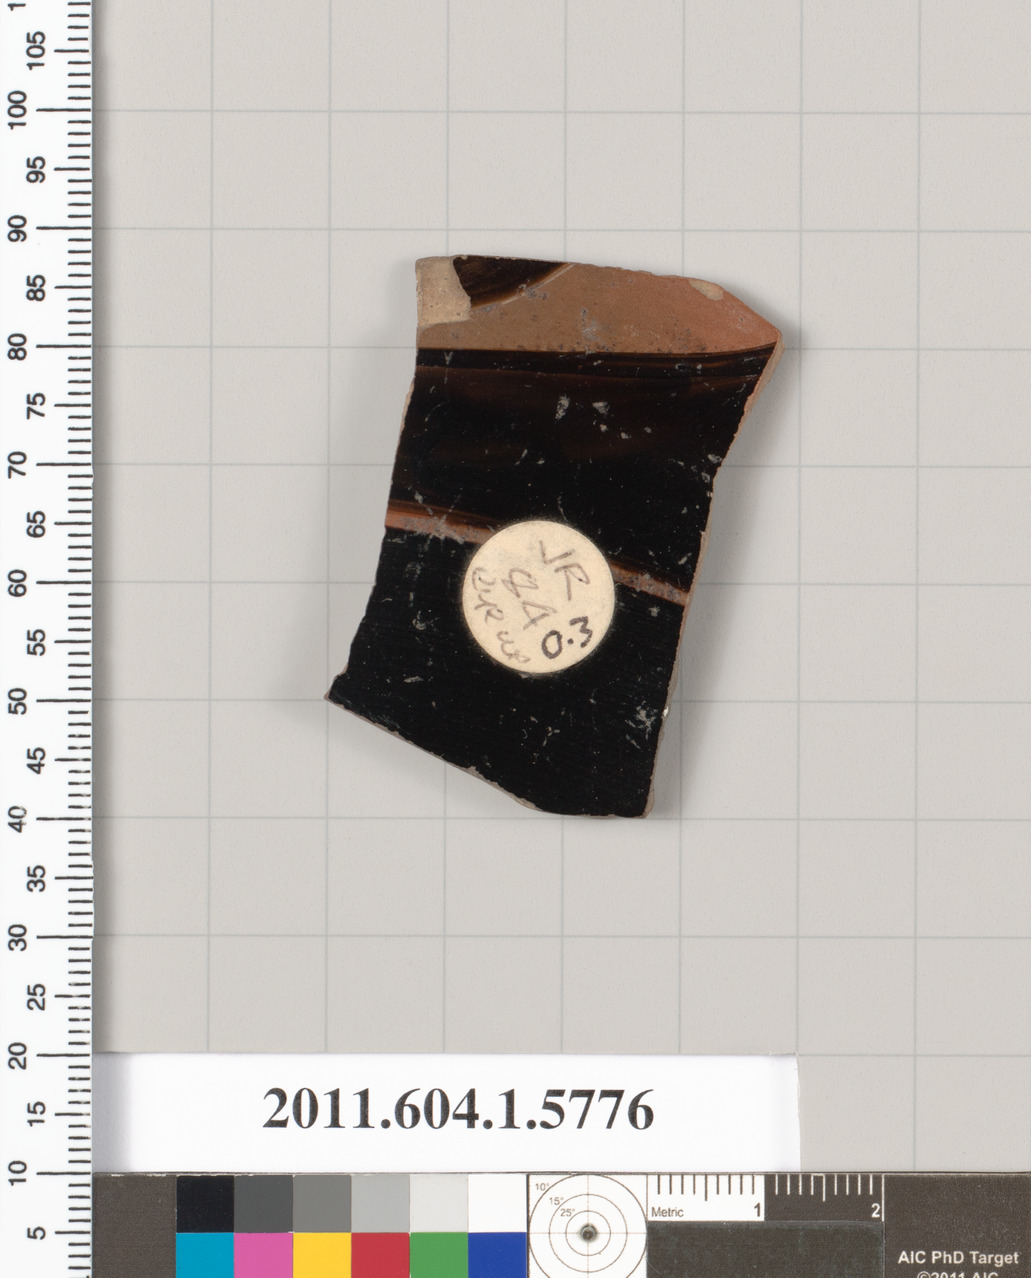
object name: kylix fragment, eye cup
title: Terracotta fragment of a kylix: eye-cup (drinking cup)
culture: greek, attic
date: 520-510 BCE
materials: terracotta